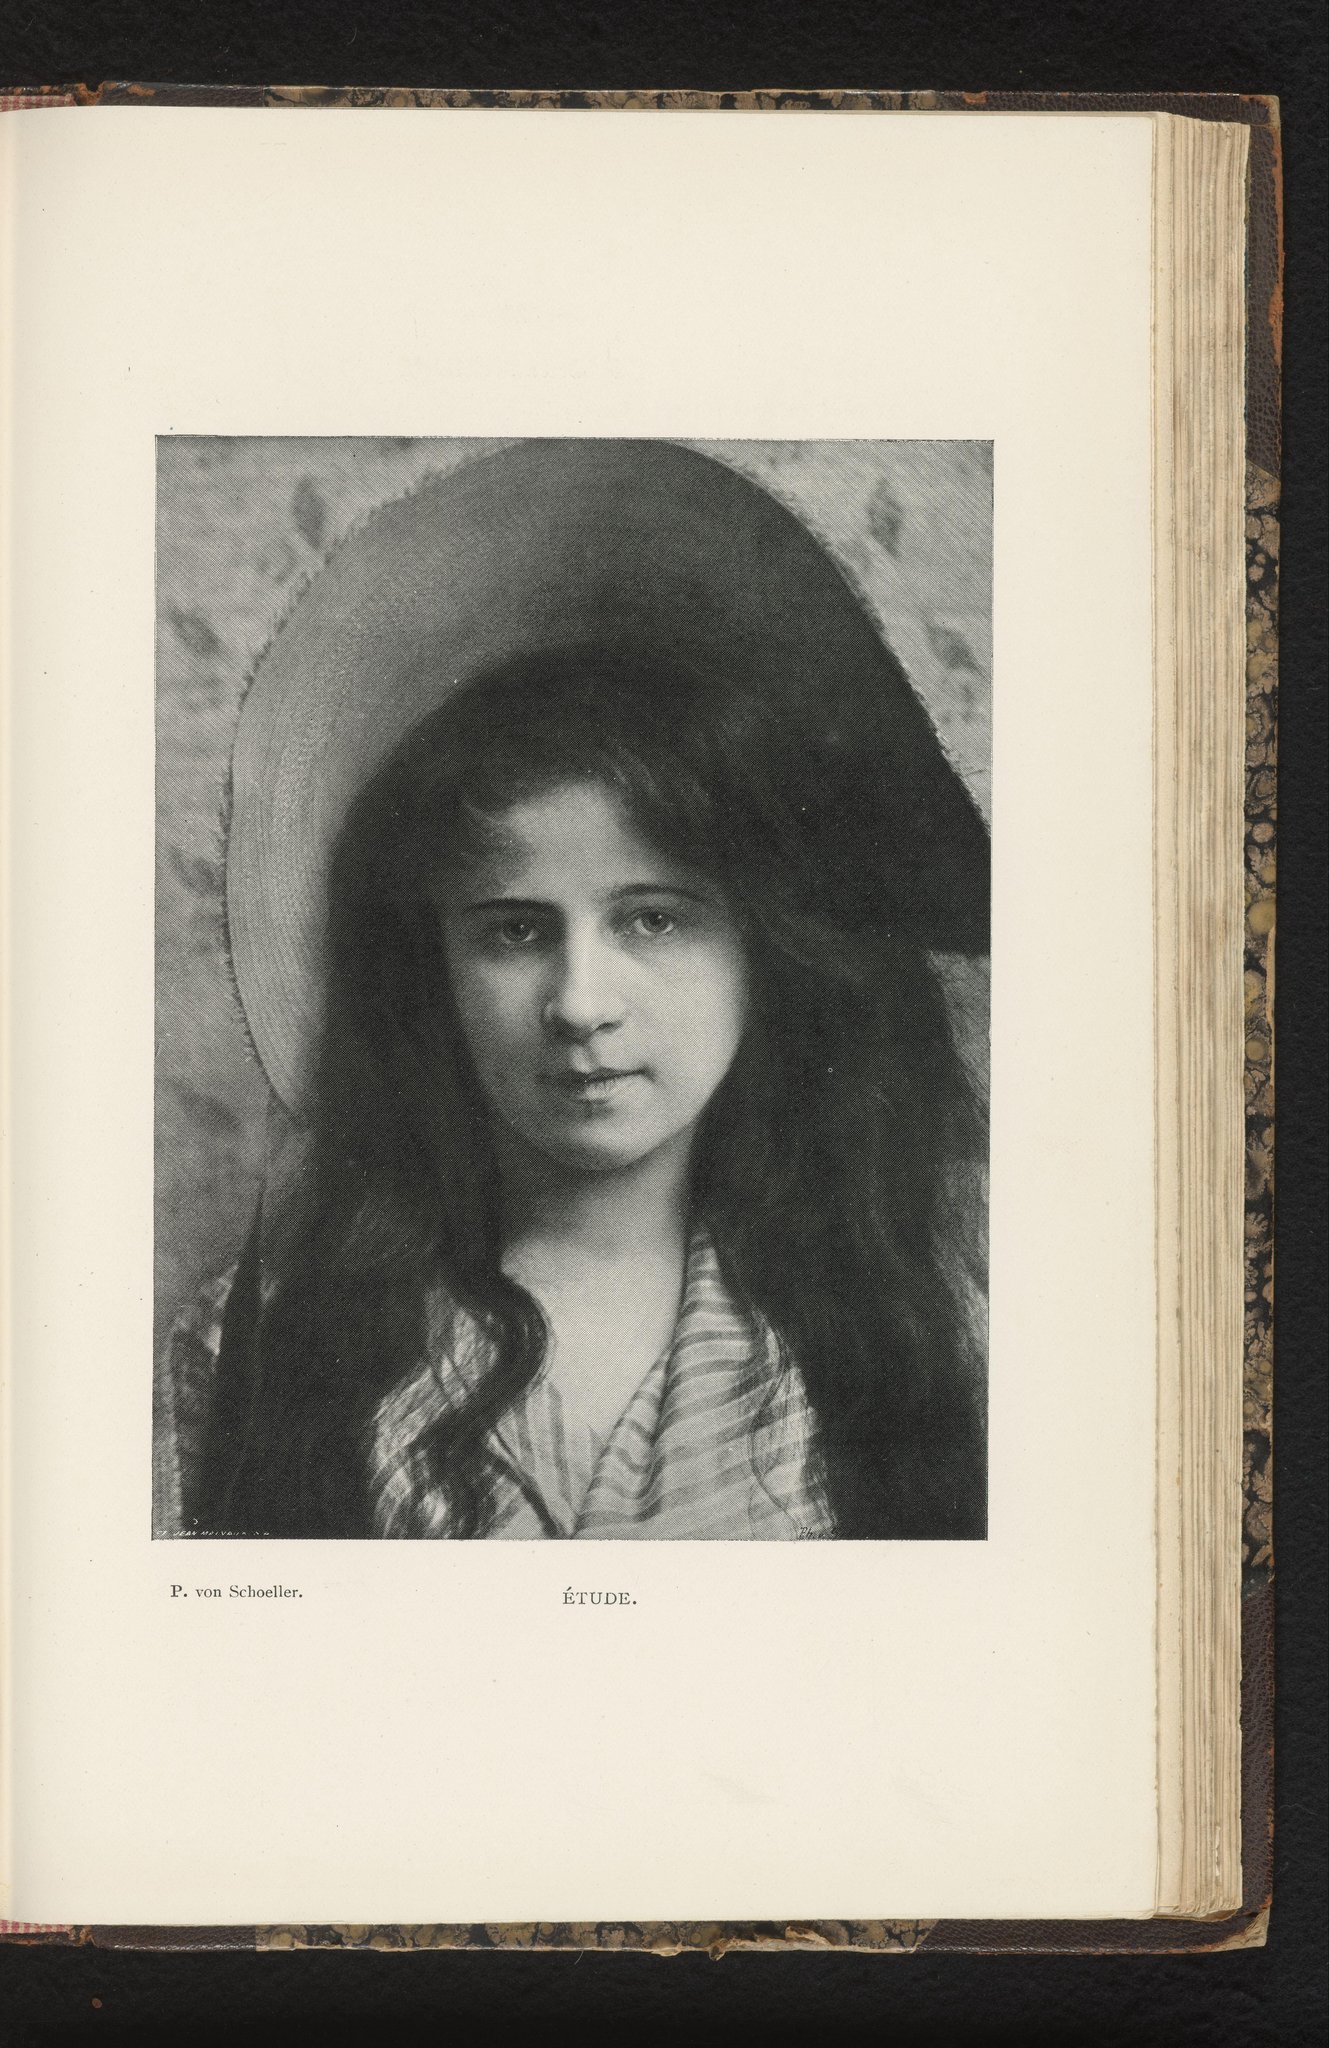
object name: photomechanical print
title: Étude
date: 1897-1902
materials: paper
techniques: autotype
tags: adolescent, young woman, maiden